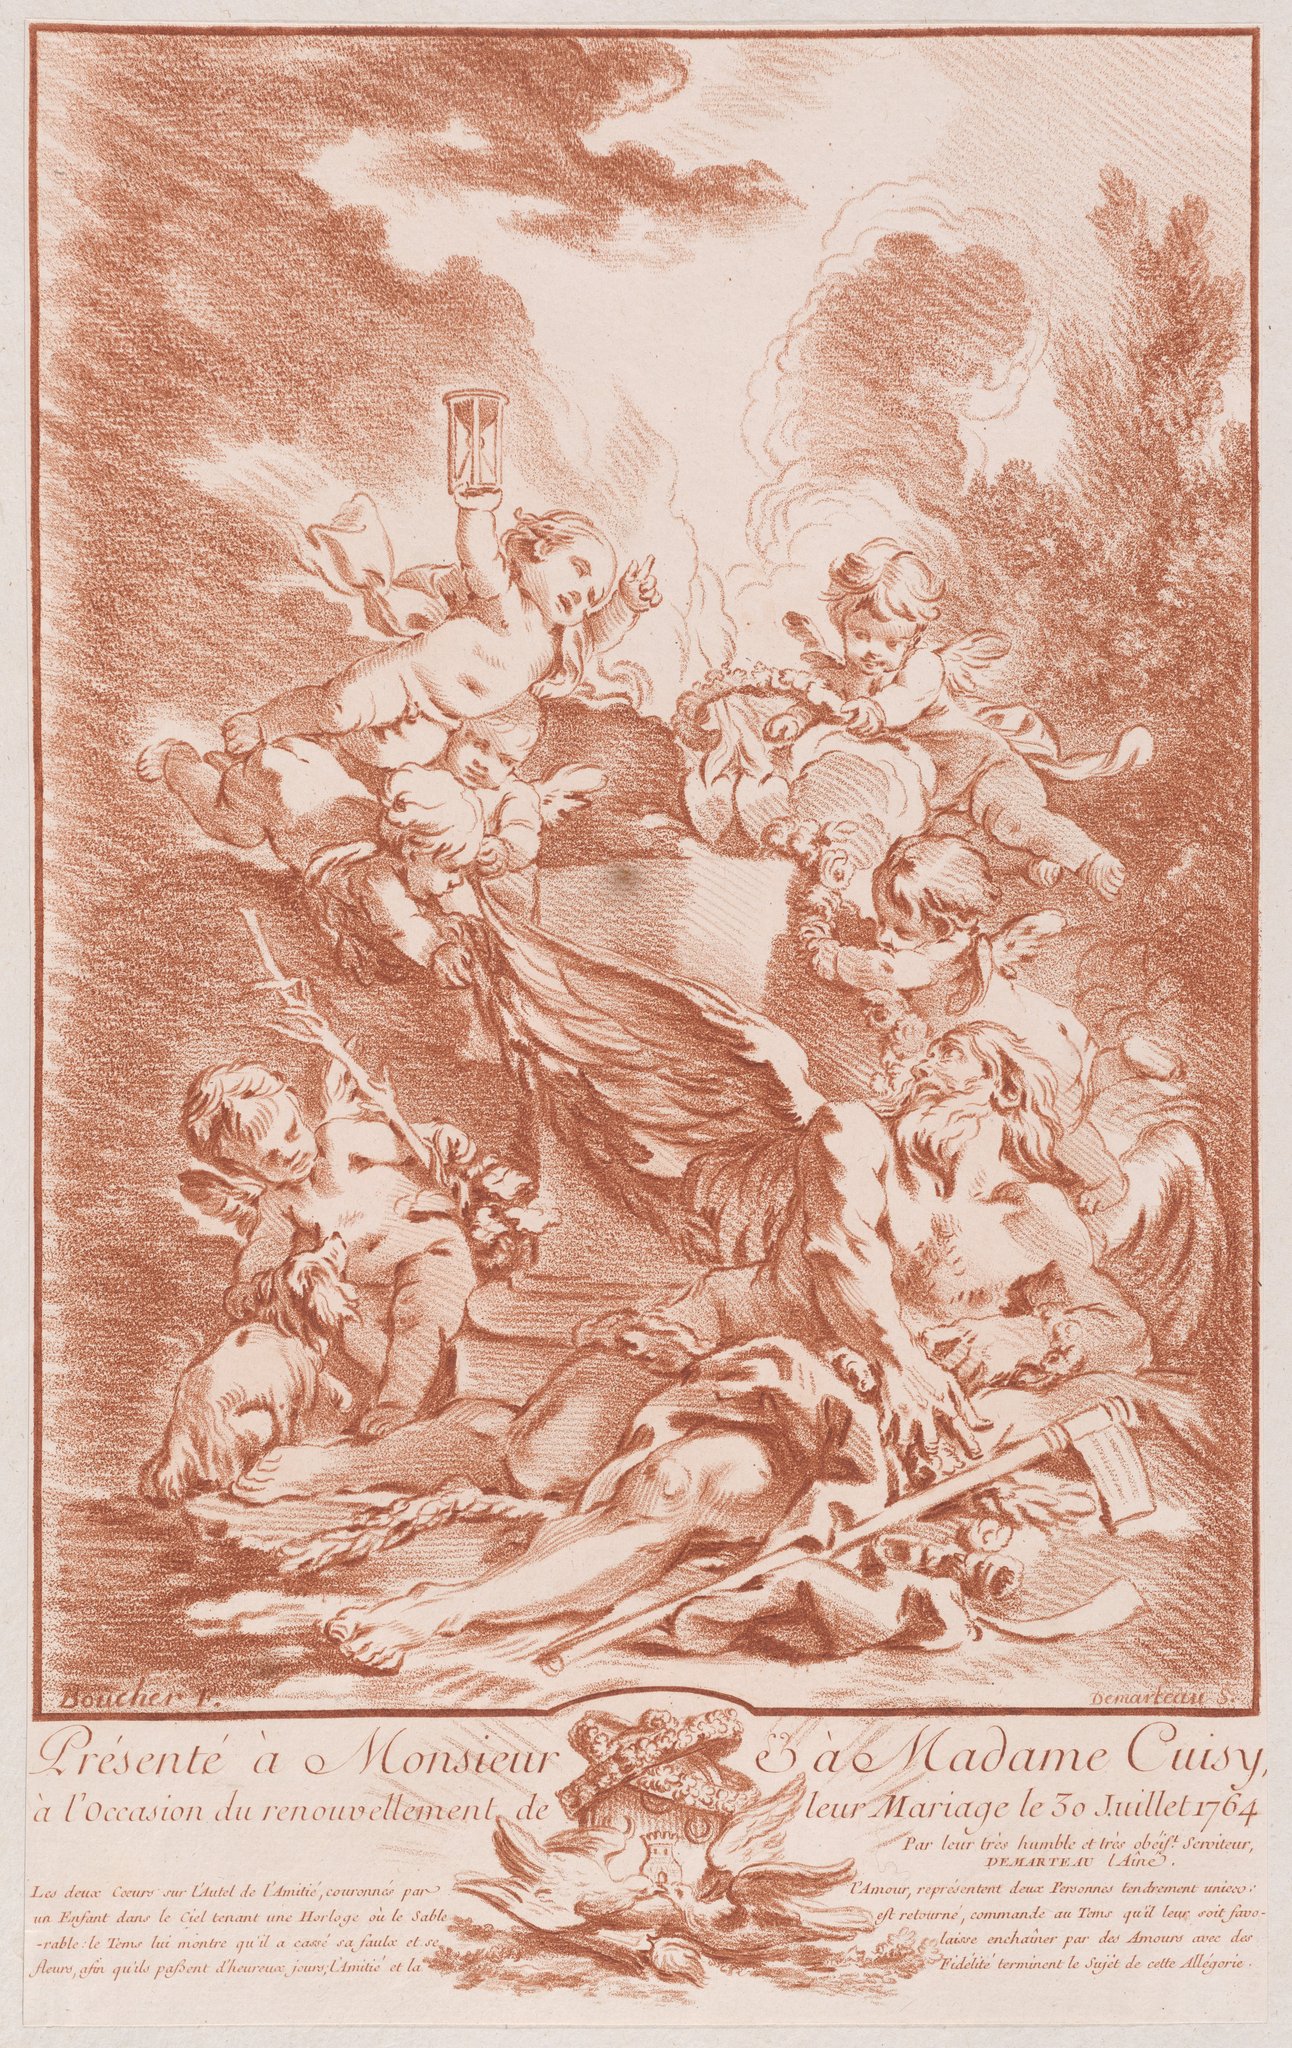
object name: print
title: Allégorie pour la commémoration d'un mariage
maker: gilles demarteau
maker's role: artist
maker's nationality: french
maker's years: 1722-1776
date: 1701-1800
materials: ink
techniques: printmaking, etching, printing